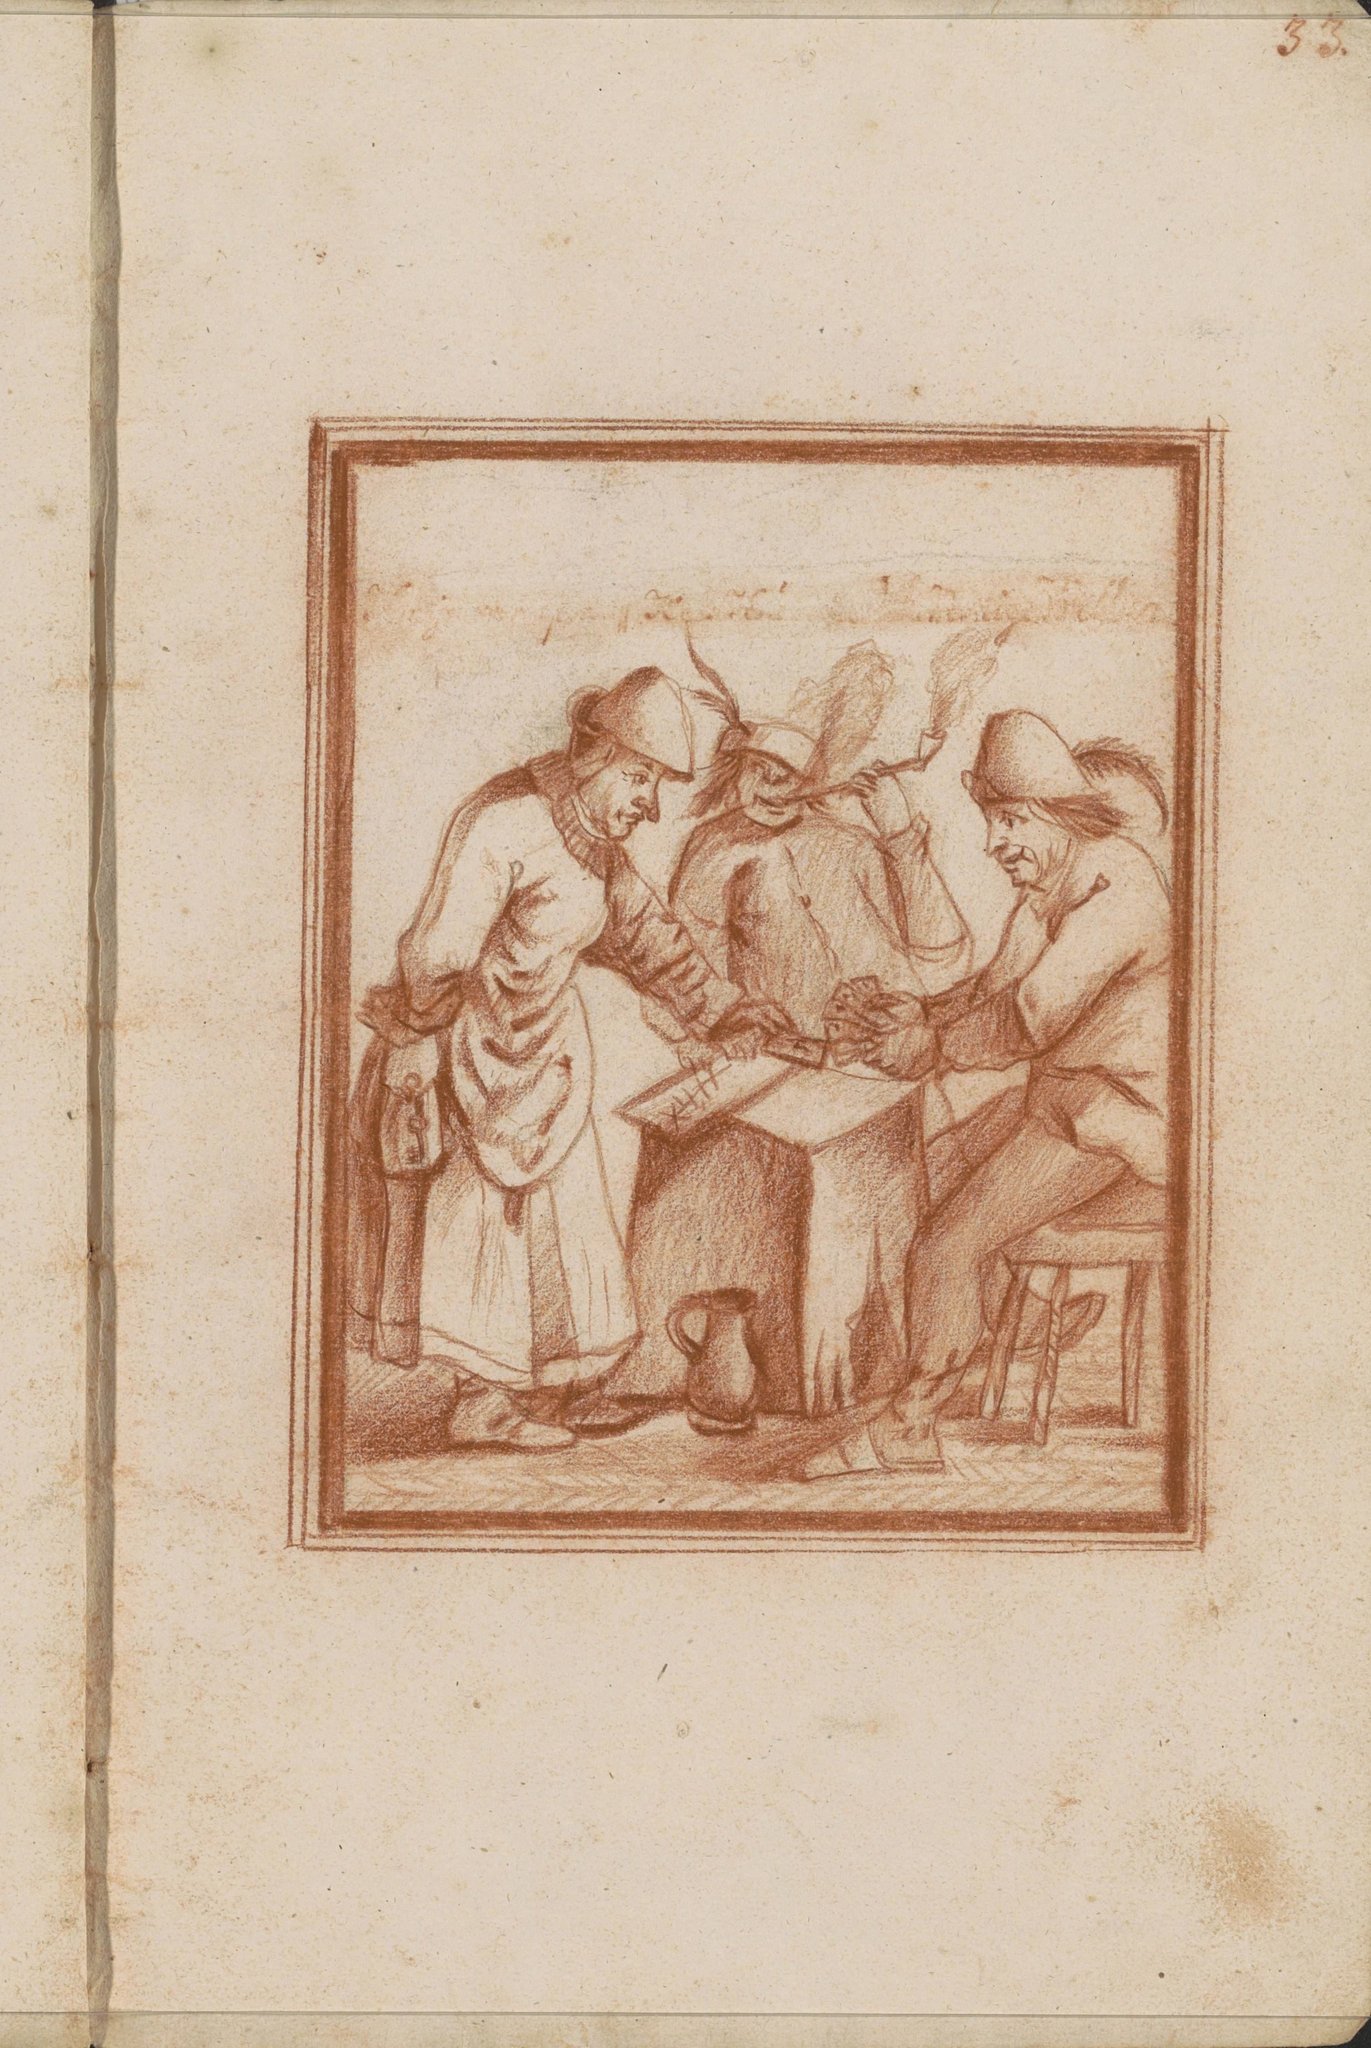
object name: sketchbook leaf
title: Boeren die een kaartspel spelen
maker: hendrick van beaumont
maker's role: draughtsman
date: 1696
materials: chalk, paper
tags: pipe ~ tobacco, farmers, playing-cards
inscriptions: number: ‘33’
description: Een man met een pijp kijkt toe hoe twee mannen een kaartspel spelen. Blad 28 recto uit een schetsboek met 30 bladen.